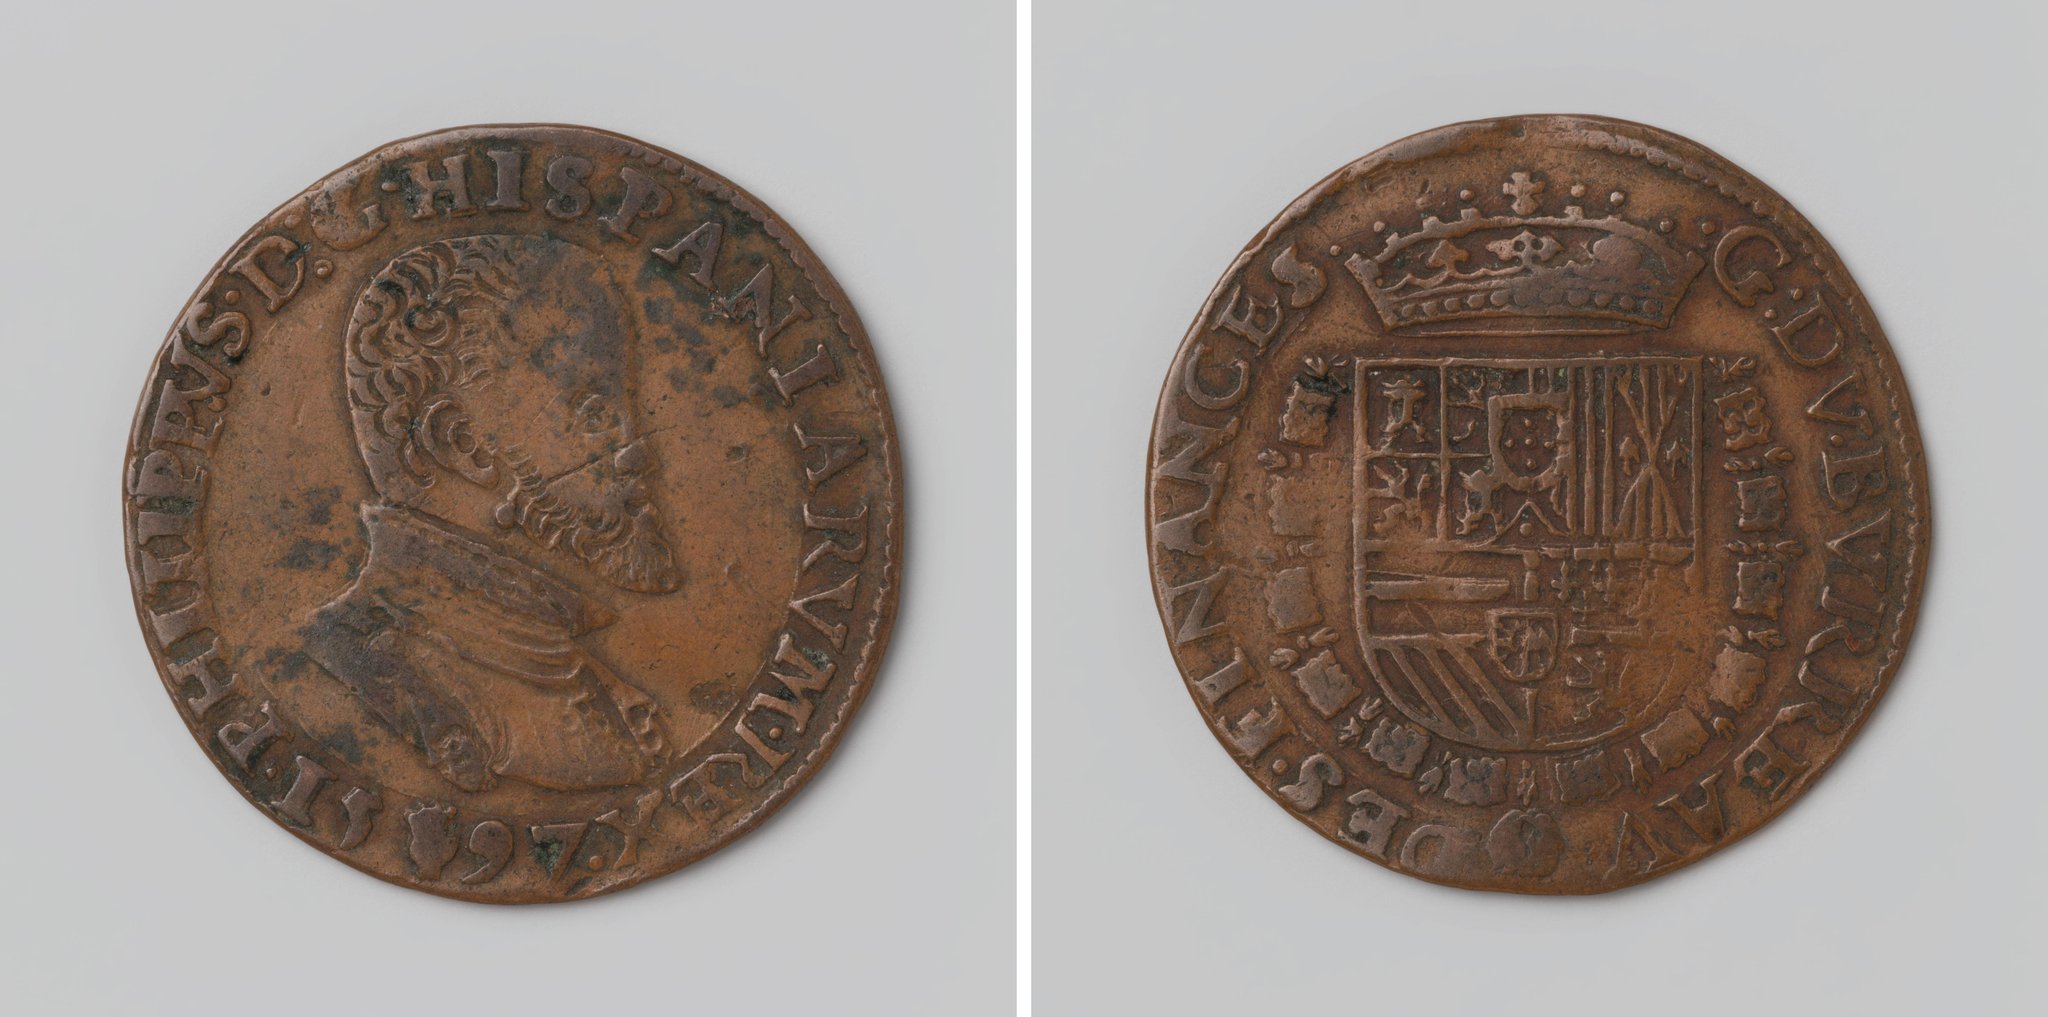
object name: jeton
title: Filips II, koning van Spanje, rekenpenning van de raad van Financiën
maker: Anonymous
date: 1597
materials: copper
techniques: striking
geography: antwerp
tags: philip ii of spain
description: Koperen penning. Voorzijde: borststuk man binnen omschrift. Keerzijde: gekroond wapenschild, omhangen met de orde van het Gulden Vlies binnen omschrift